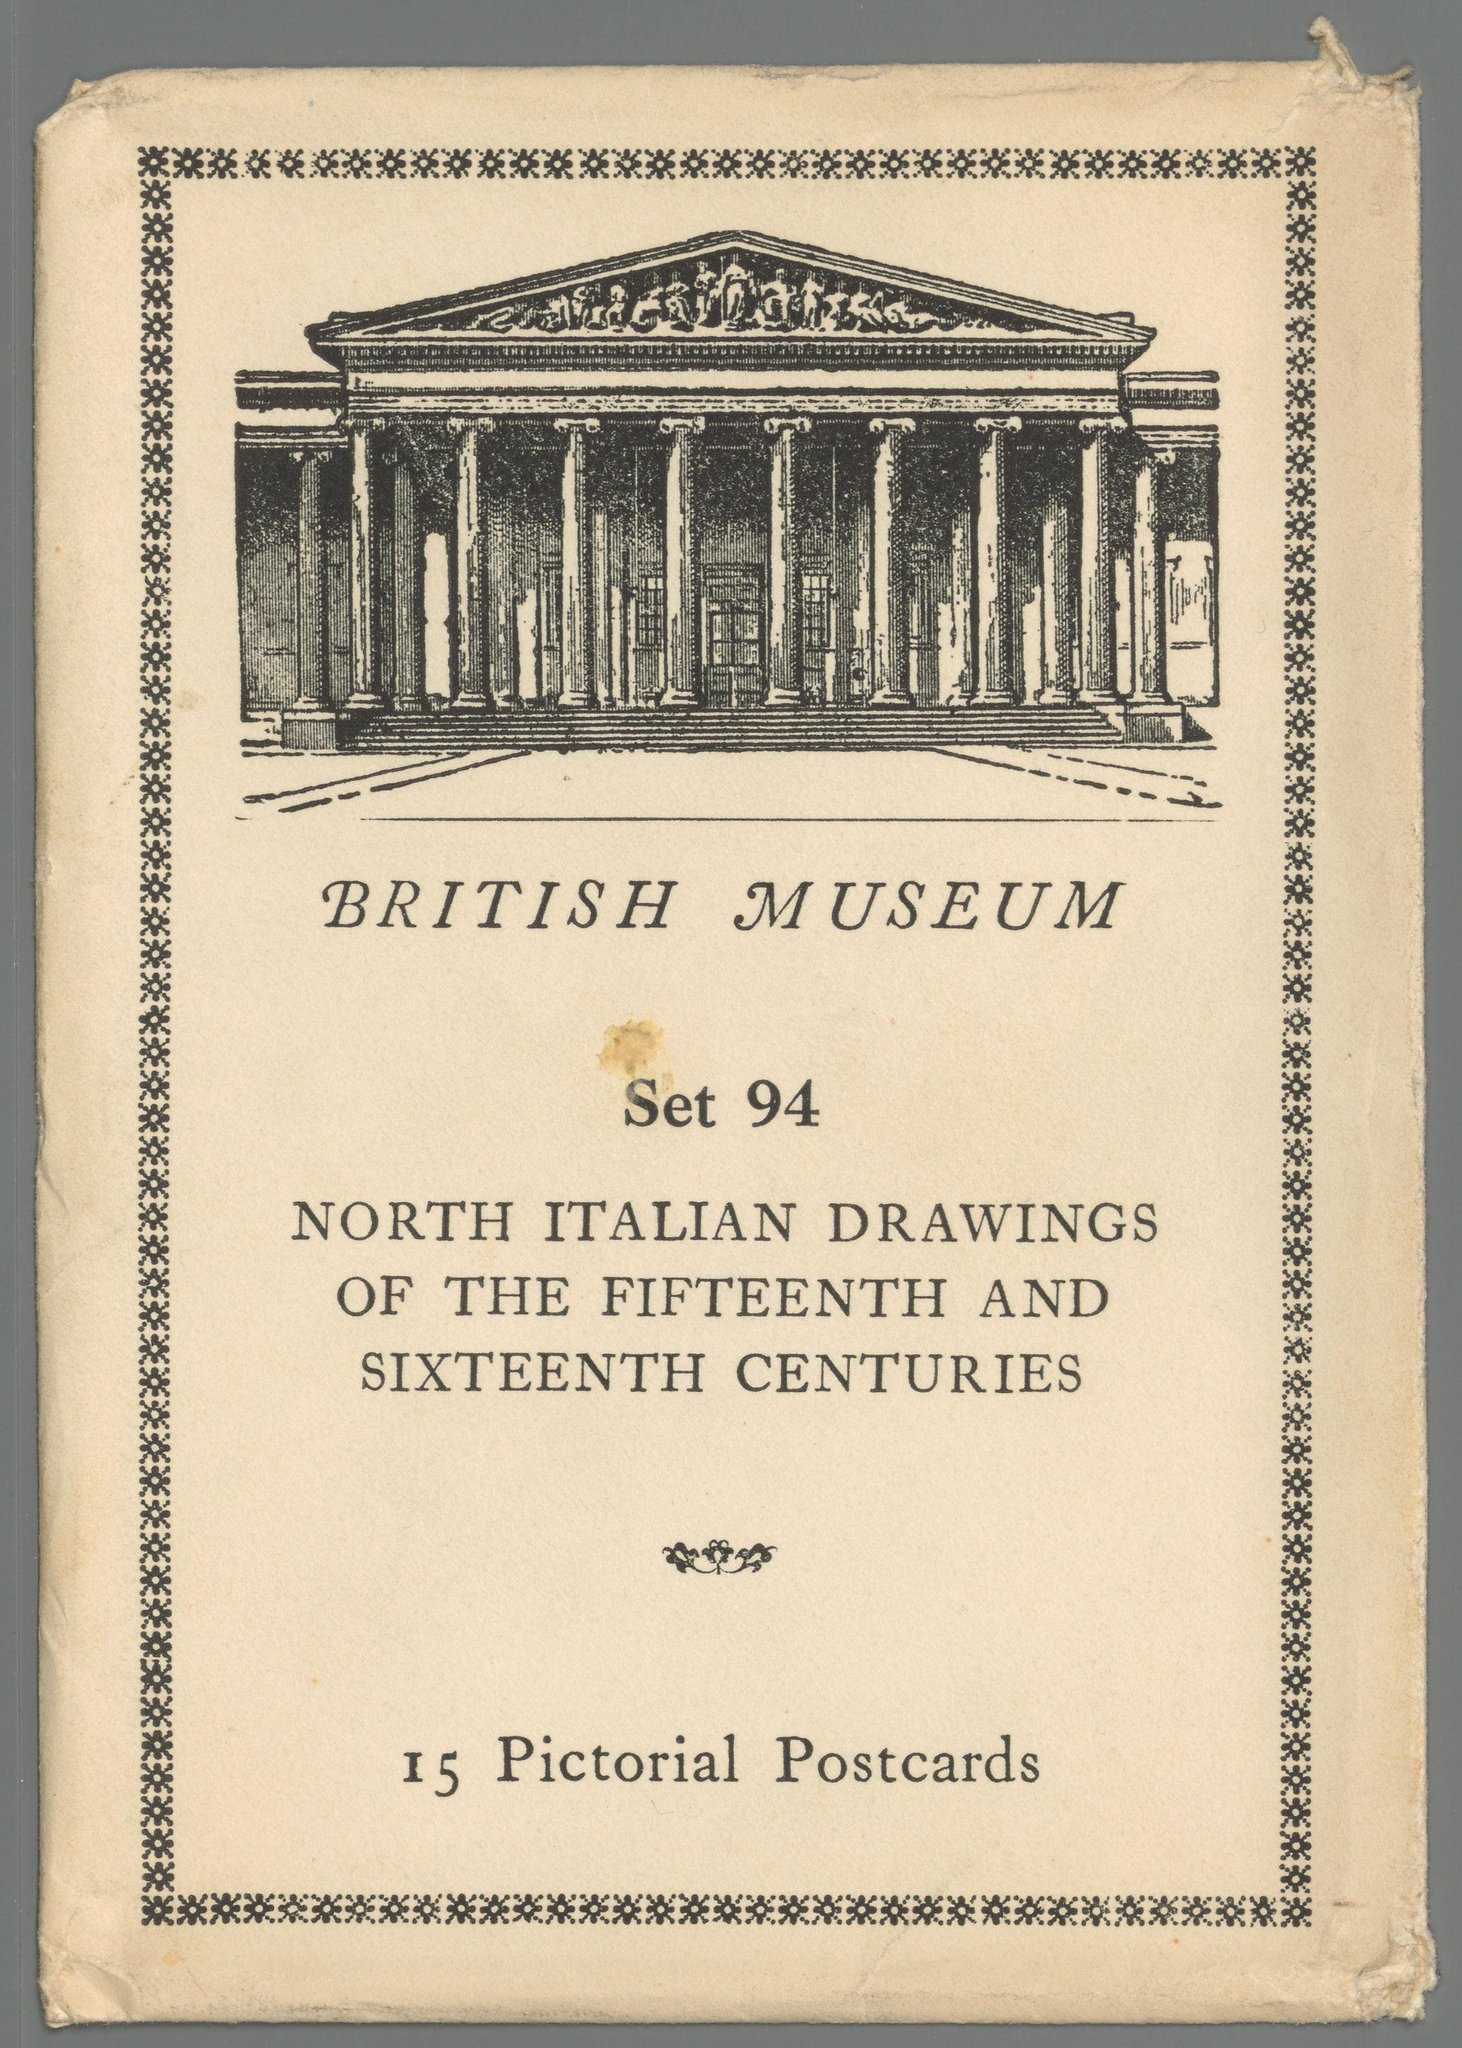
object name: photomechanical print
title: Omslag voor veertien prentbriefkaarten met kunstreproducties uit het British Museum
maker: Anonymous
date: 1902-1950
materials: cardboard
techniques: printing block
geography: oxford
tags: permanent exhibition, museum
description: In de omslag zit een papier ingestoken met daarop een beschrijving van de inhoud. Het omslag is bedoeld voor vijftien prentbriefkaarten. In dit exemplaar zijn veertien prentbriefkaarten aangetroffen.